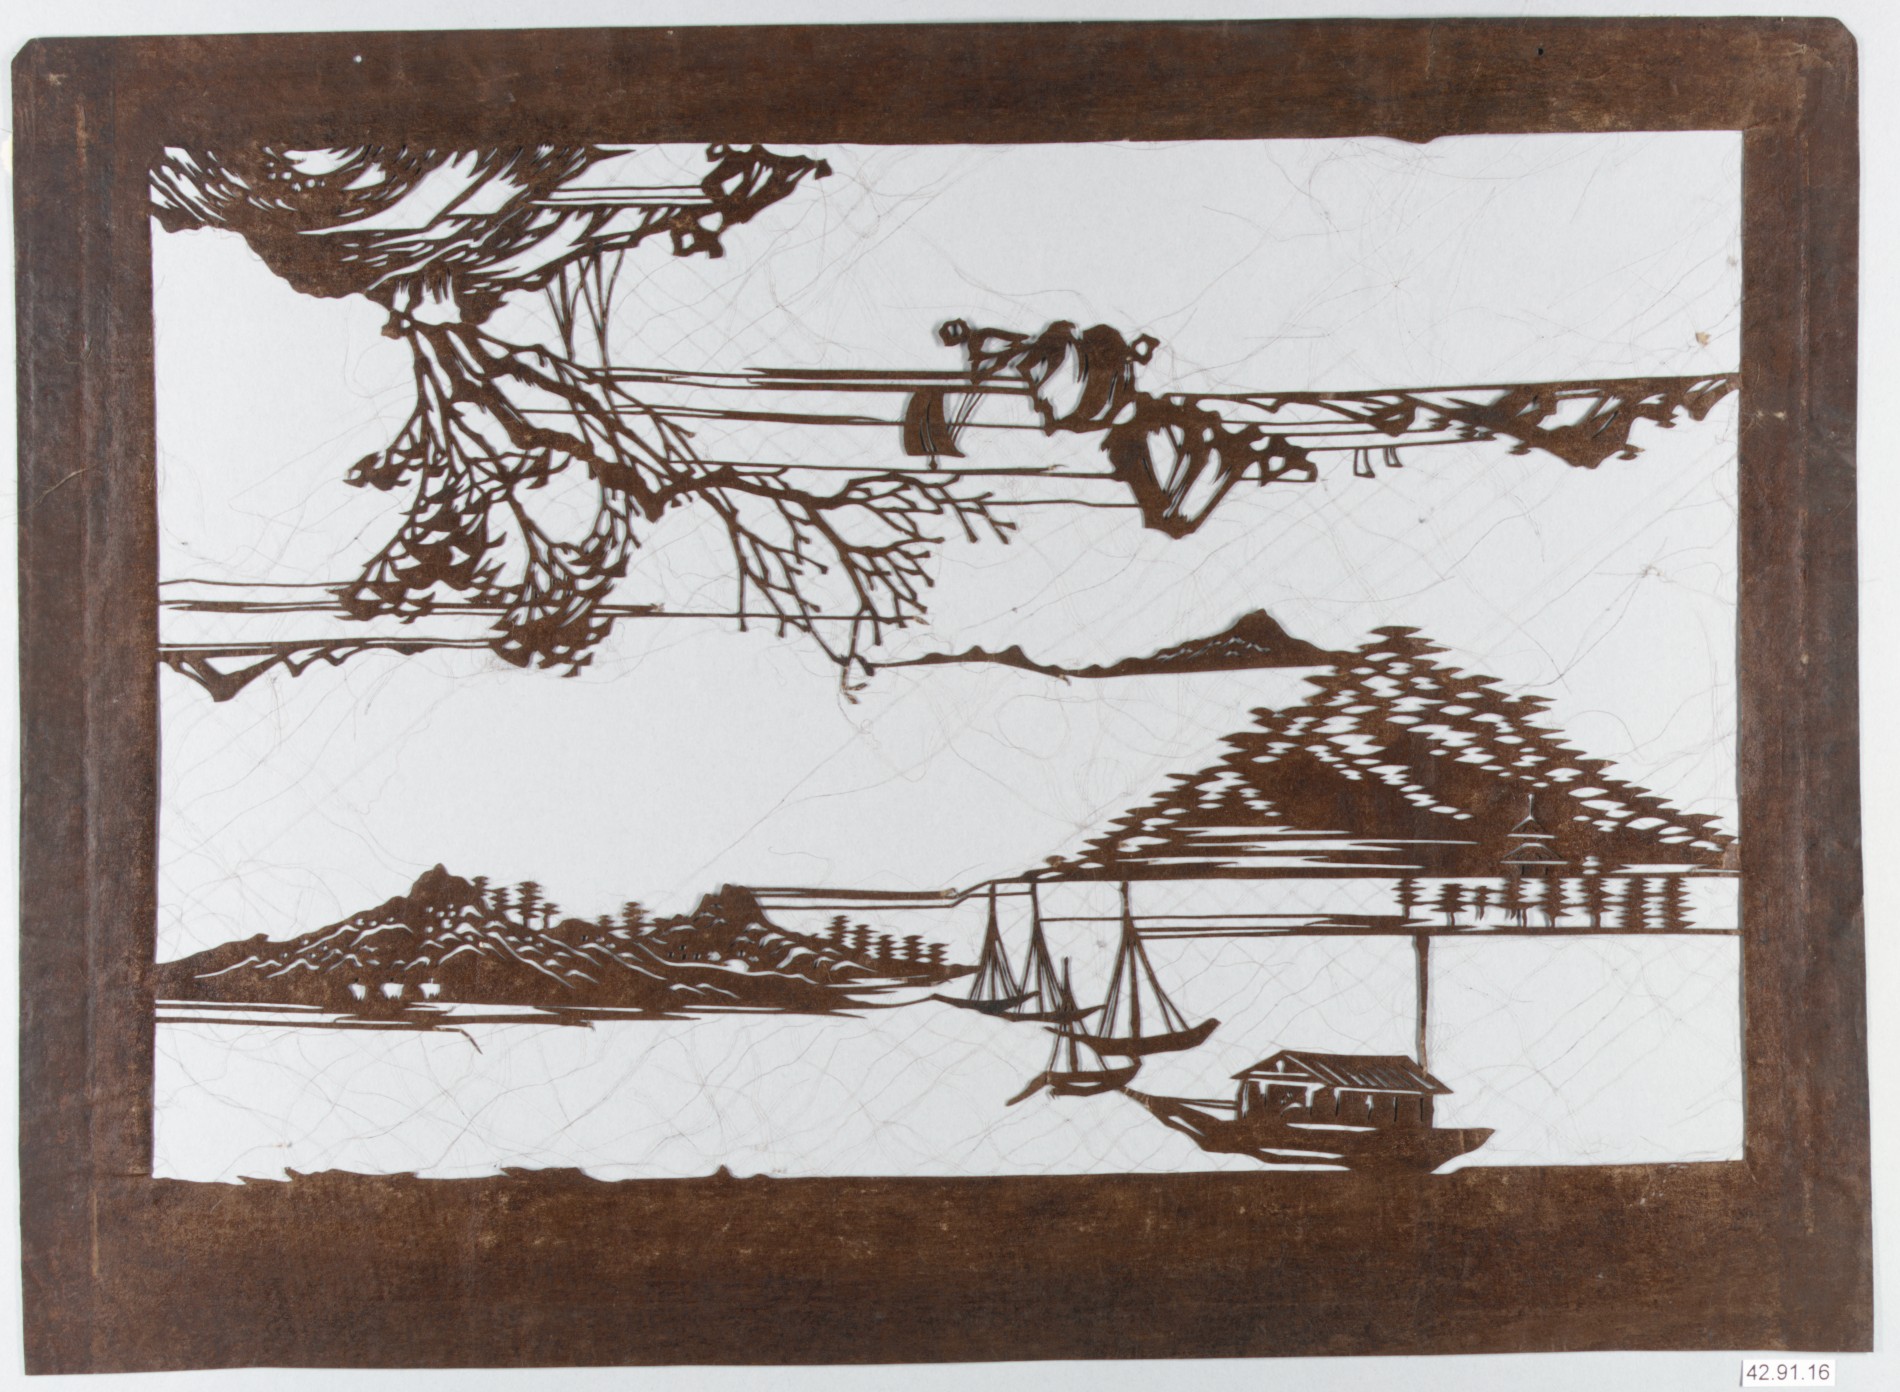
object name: stencil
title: Stencil with Pattern of Seascape on White Ground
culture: japanese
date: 1801-1900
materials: paper, silk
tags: seascapes,boats